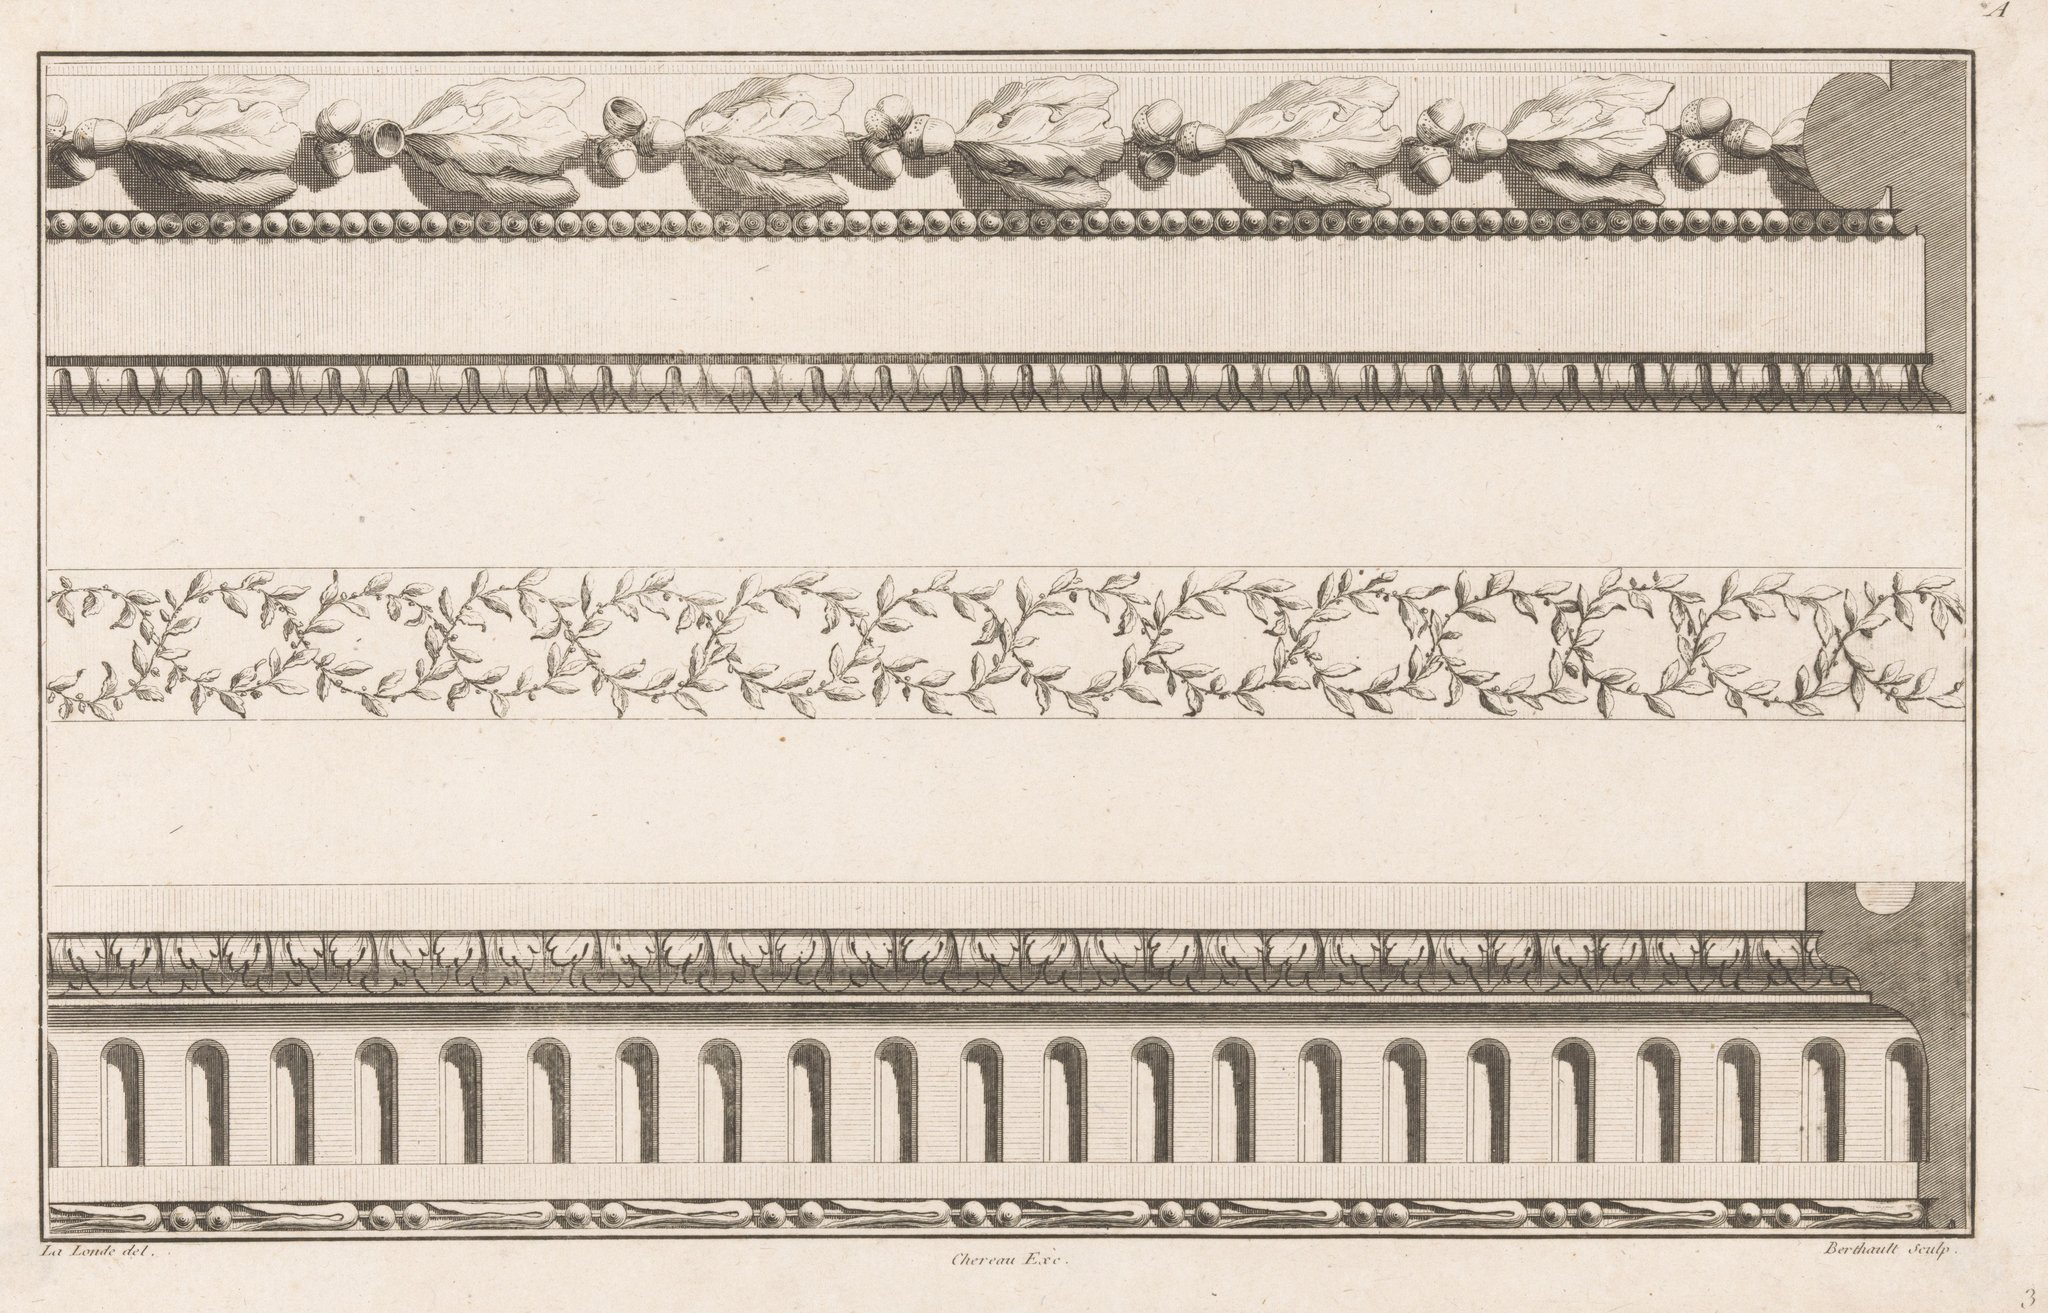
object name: ornament print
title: A Cahier de Bordures à l'usage de la Sculpture &c, avec leurs Profils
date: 1784-1785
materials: paper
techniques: engraving, etching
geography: paris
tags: ornaments ~ art (+ framing decorations)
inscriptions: collector's mark: Lugt 2760, collector's mark: Lugt 2228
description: Een lijst met eikenbladeren, een lijst met twee ranken en een lijst met acanthusbladeren.